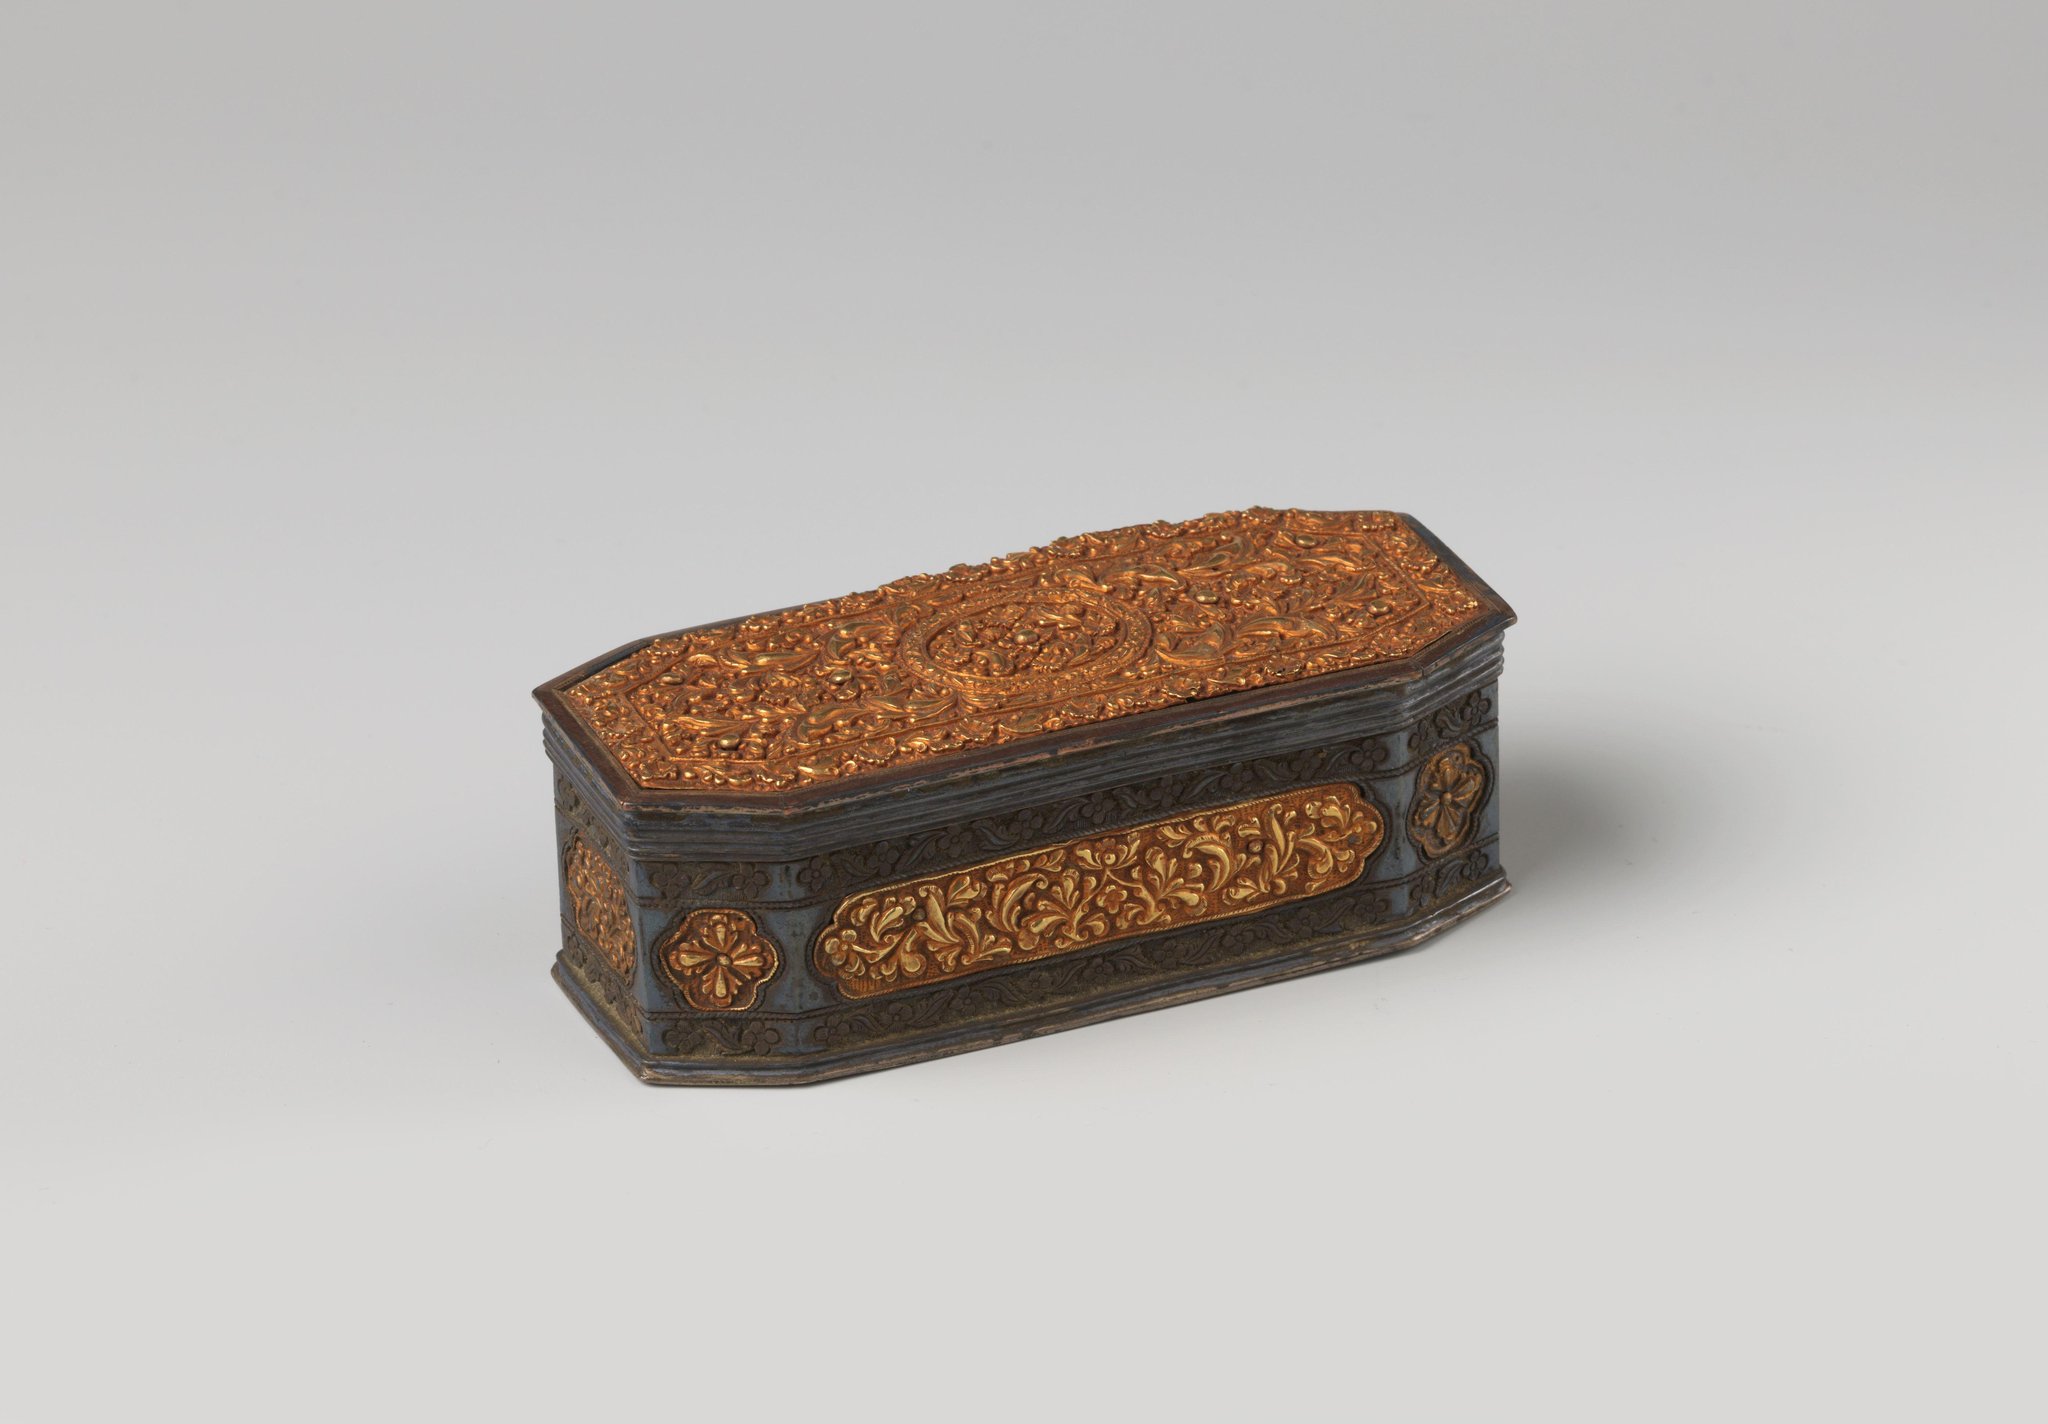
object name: sirihkist, sirihdoos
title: Tabaksdoos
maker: Anonymous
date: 1855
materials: gold, silver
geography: sumatra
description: Sirih-doos, tabaksdoos, achthoekig, versierd met bloemmotieven aangebracht op de gouden plaques die zich op alle zijden en het vlakke deksel bevinden.